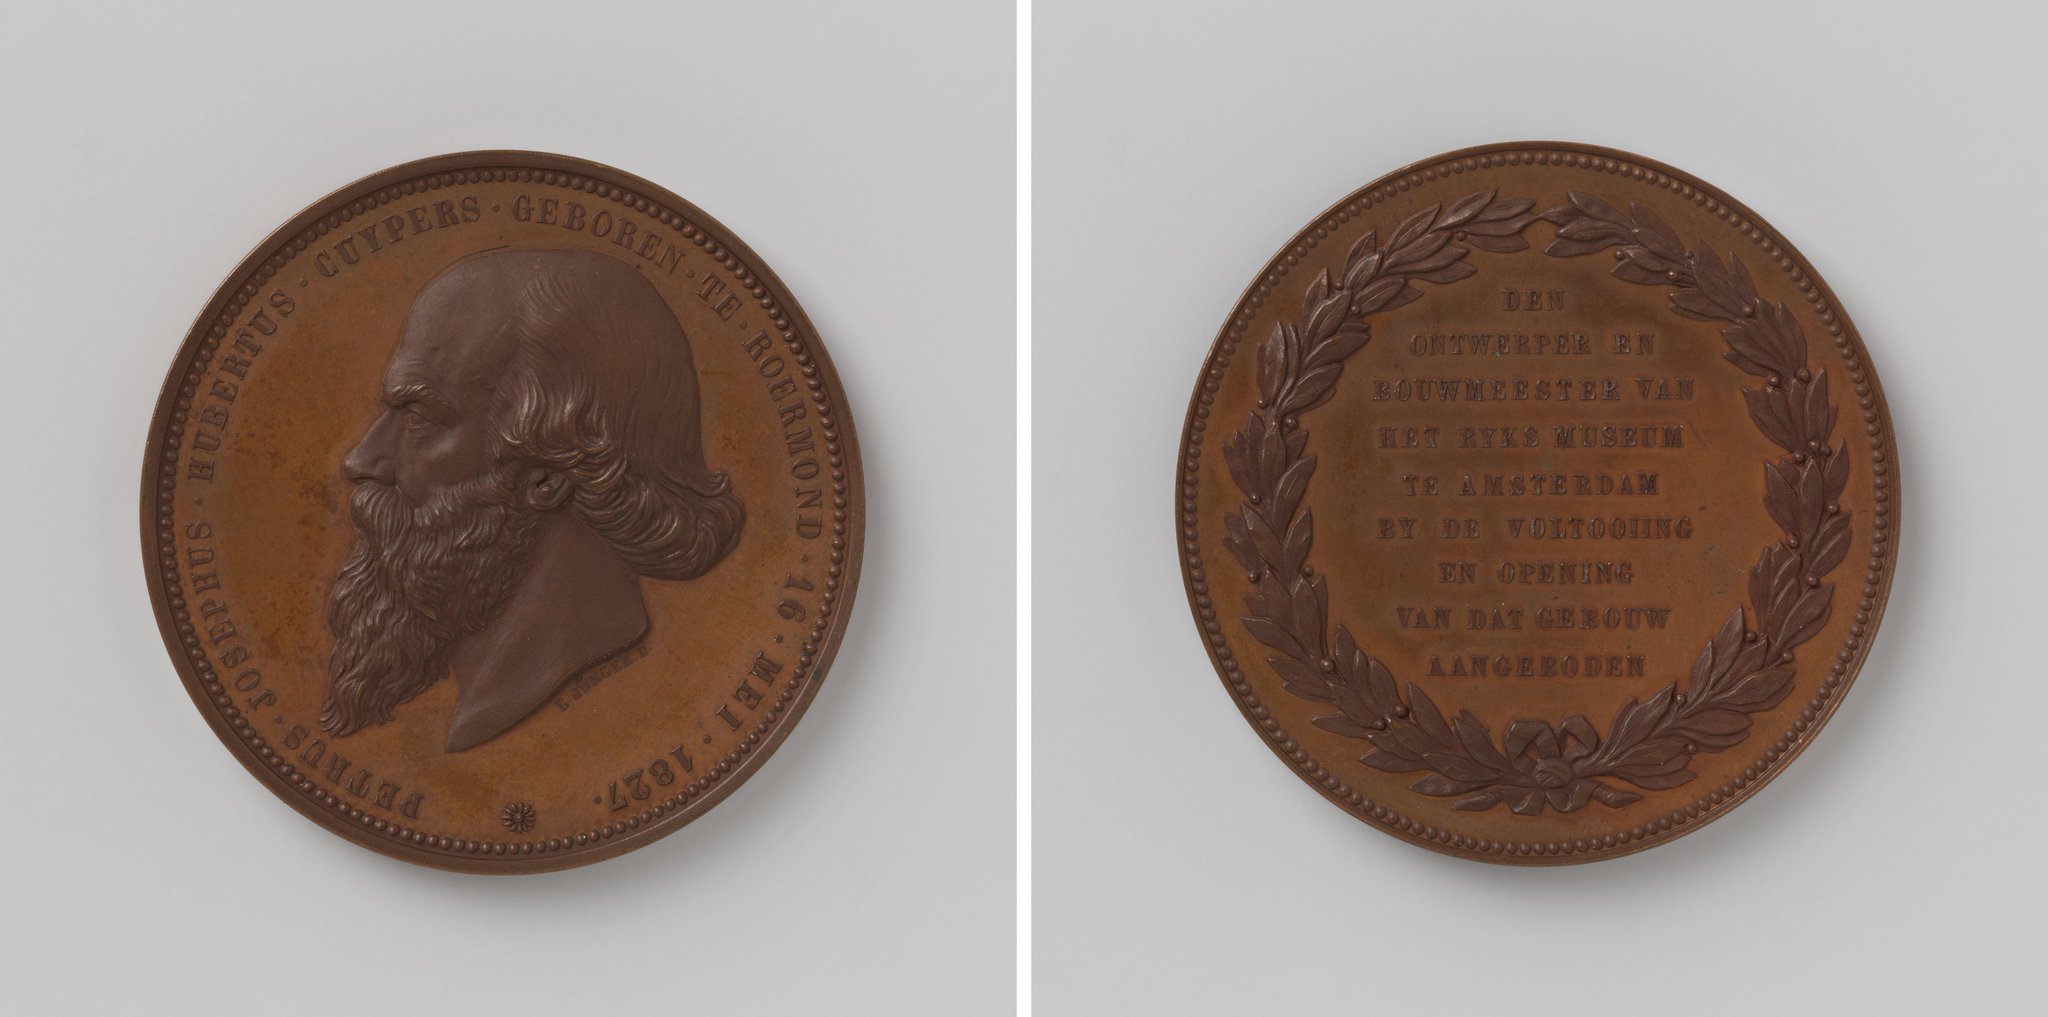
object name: honorary medal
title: P.J.H. Cuypers, penning aangeboden bij de opening van het Rijksmuseum te Amsterdam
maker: ludwig jünger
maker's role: medailleur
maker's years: 1857-1908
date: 1885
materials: bronze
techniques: striking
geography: utrecht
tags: draughtsman, pierre joseph hubert cuypers, rijksmuseum amsterdam, amsterdam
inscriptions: inscription: ‘J.P.M.F.’, circumscription: ‘PETRUS . JOSEPHUS . HUBERTUS . CUYPERS . GEBOREN . TE . ROERMOND . 16 . MEI . 1827’, signature: ‘L. JÜNGER . D .’, inscription: ‘DEN / ONTWERPER EN / BOUWMEESTER VAN / HET RYKS MUSEUM / TE AMSTERDAM / BY DE VOLTOOIING / EN OPENING / VAN DAT GEBOUW / AANGEBODEN’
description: Bronzen penning. Voorzijde: naar links gekeerd profiel van Cuypers in reliëf binnen omschrift. Keerzijde: opschrift binnen lauwerkrans.